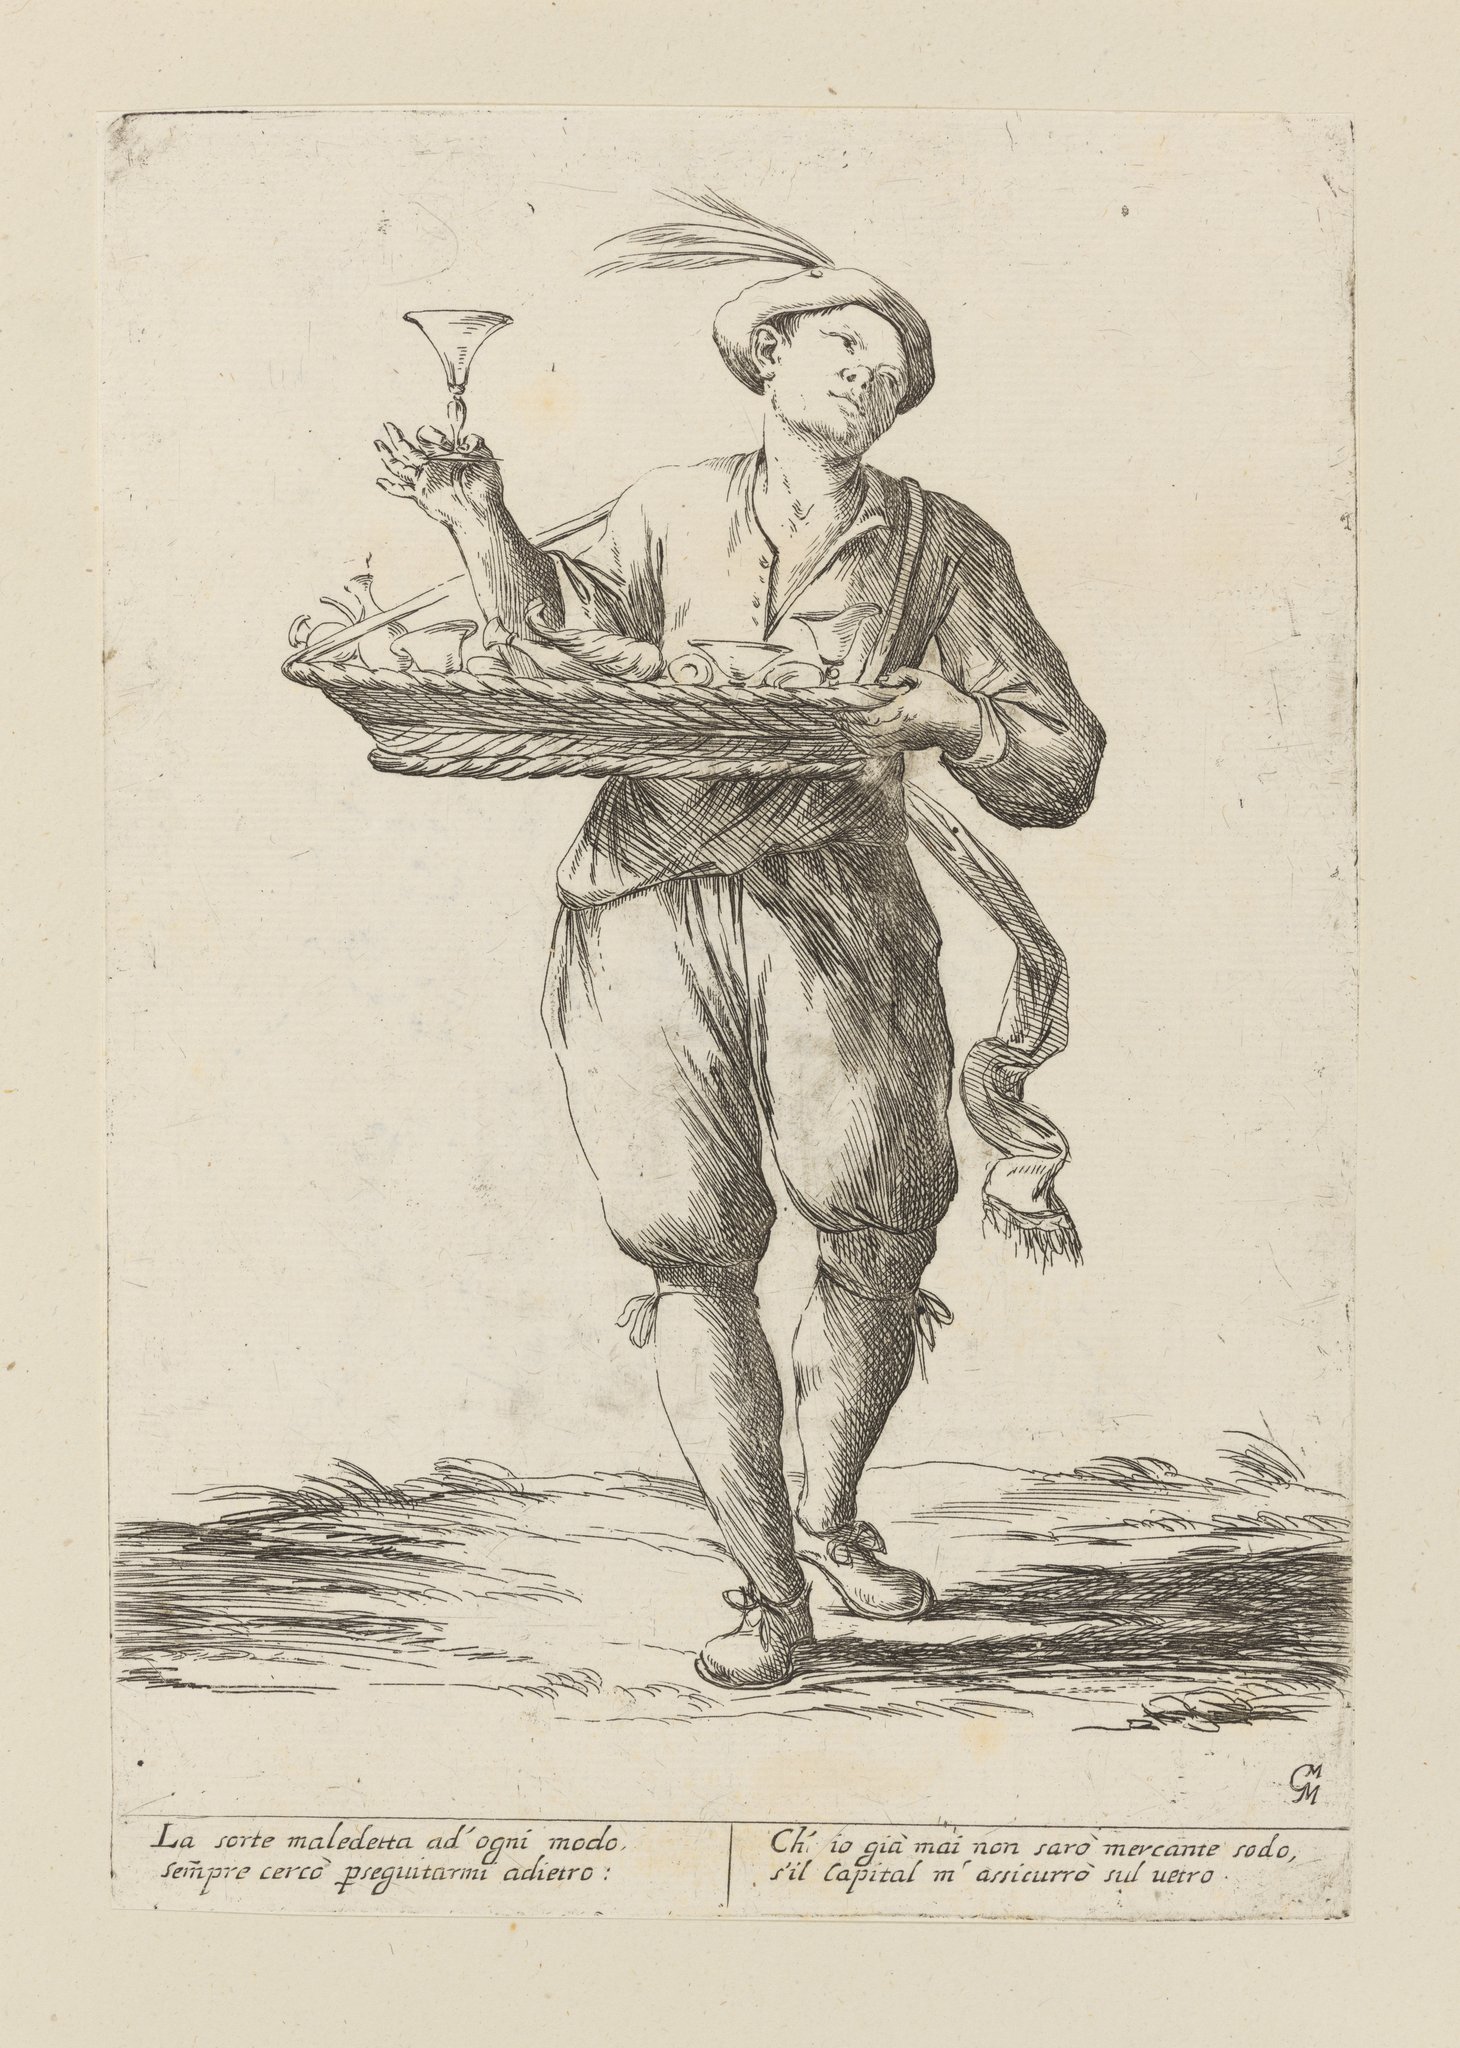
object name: print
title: Vendor of Glassware, from Di Bologna l'Arti per via D'An.ibal' Ca.rac, plate 19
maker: giuseppe maria mitelli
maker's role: artist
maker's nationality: italian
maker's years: 1634-1718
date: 1660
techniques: etching